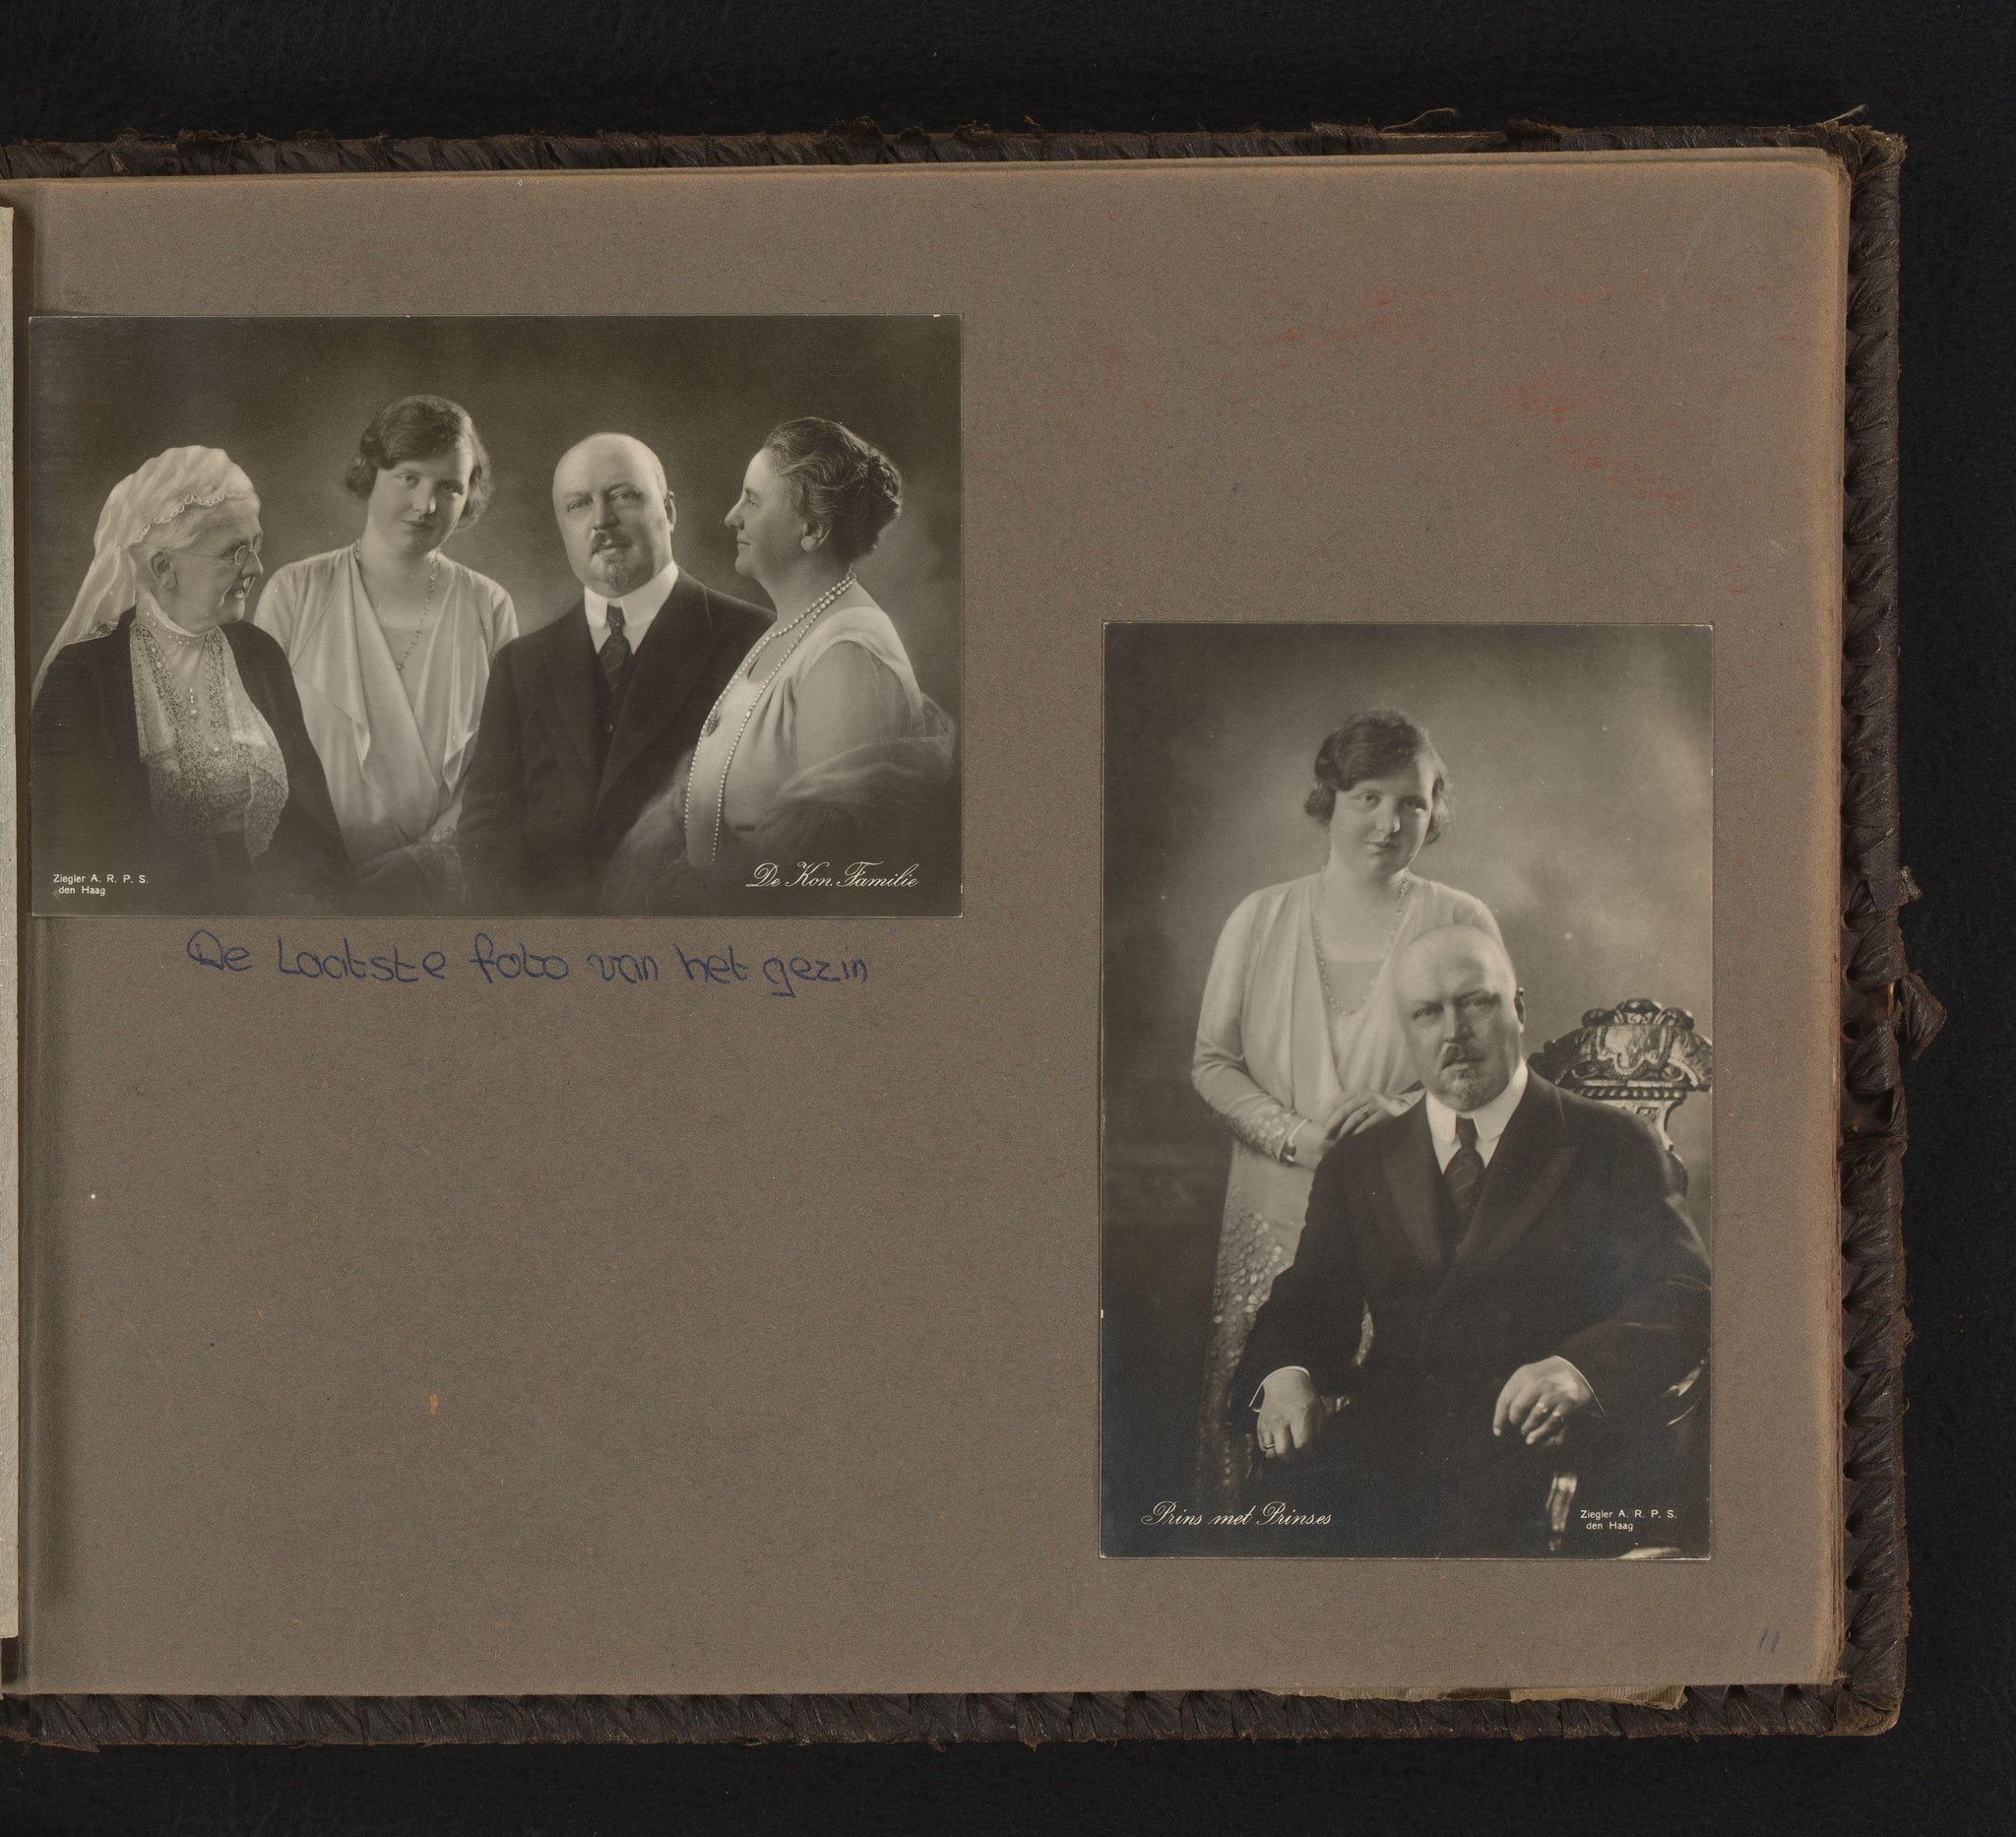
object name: photograph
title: Twee groepsportretten van de koninklijke familie: koningin-moeder Emma, koningin Wilhelmina, prins Hendrik en prinses Juliana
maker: franz ziegler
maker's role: fotograaf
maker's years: 1893-1939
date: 1930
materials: paper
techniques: gelatin silver print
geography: the hague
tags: print maker, wilhelmina of the netherlands, hendrik (prins der nederlanden (1876-1934)), emma (queen consort of the netherlands), the hague, juliana of the netherlands, adolescent, young woman, maiden, adult woman, adult man, historical persons, old woman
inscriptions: inscription: ‘Ziegler A.R.P.S./ den Haag/ De Kon. Familie’, annotation: ‘De laatste foto van het gezin’, inscription: ‘Prins met Prinses/ Ziegler A.R.P.S./ den Haag’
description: Deze foto's maken deel uit van een album.